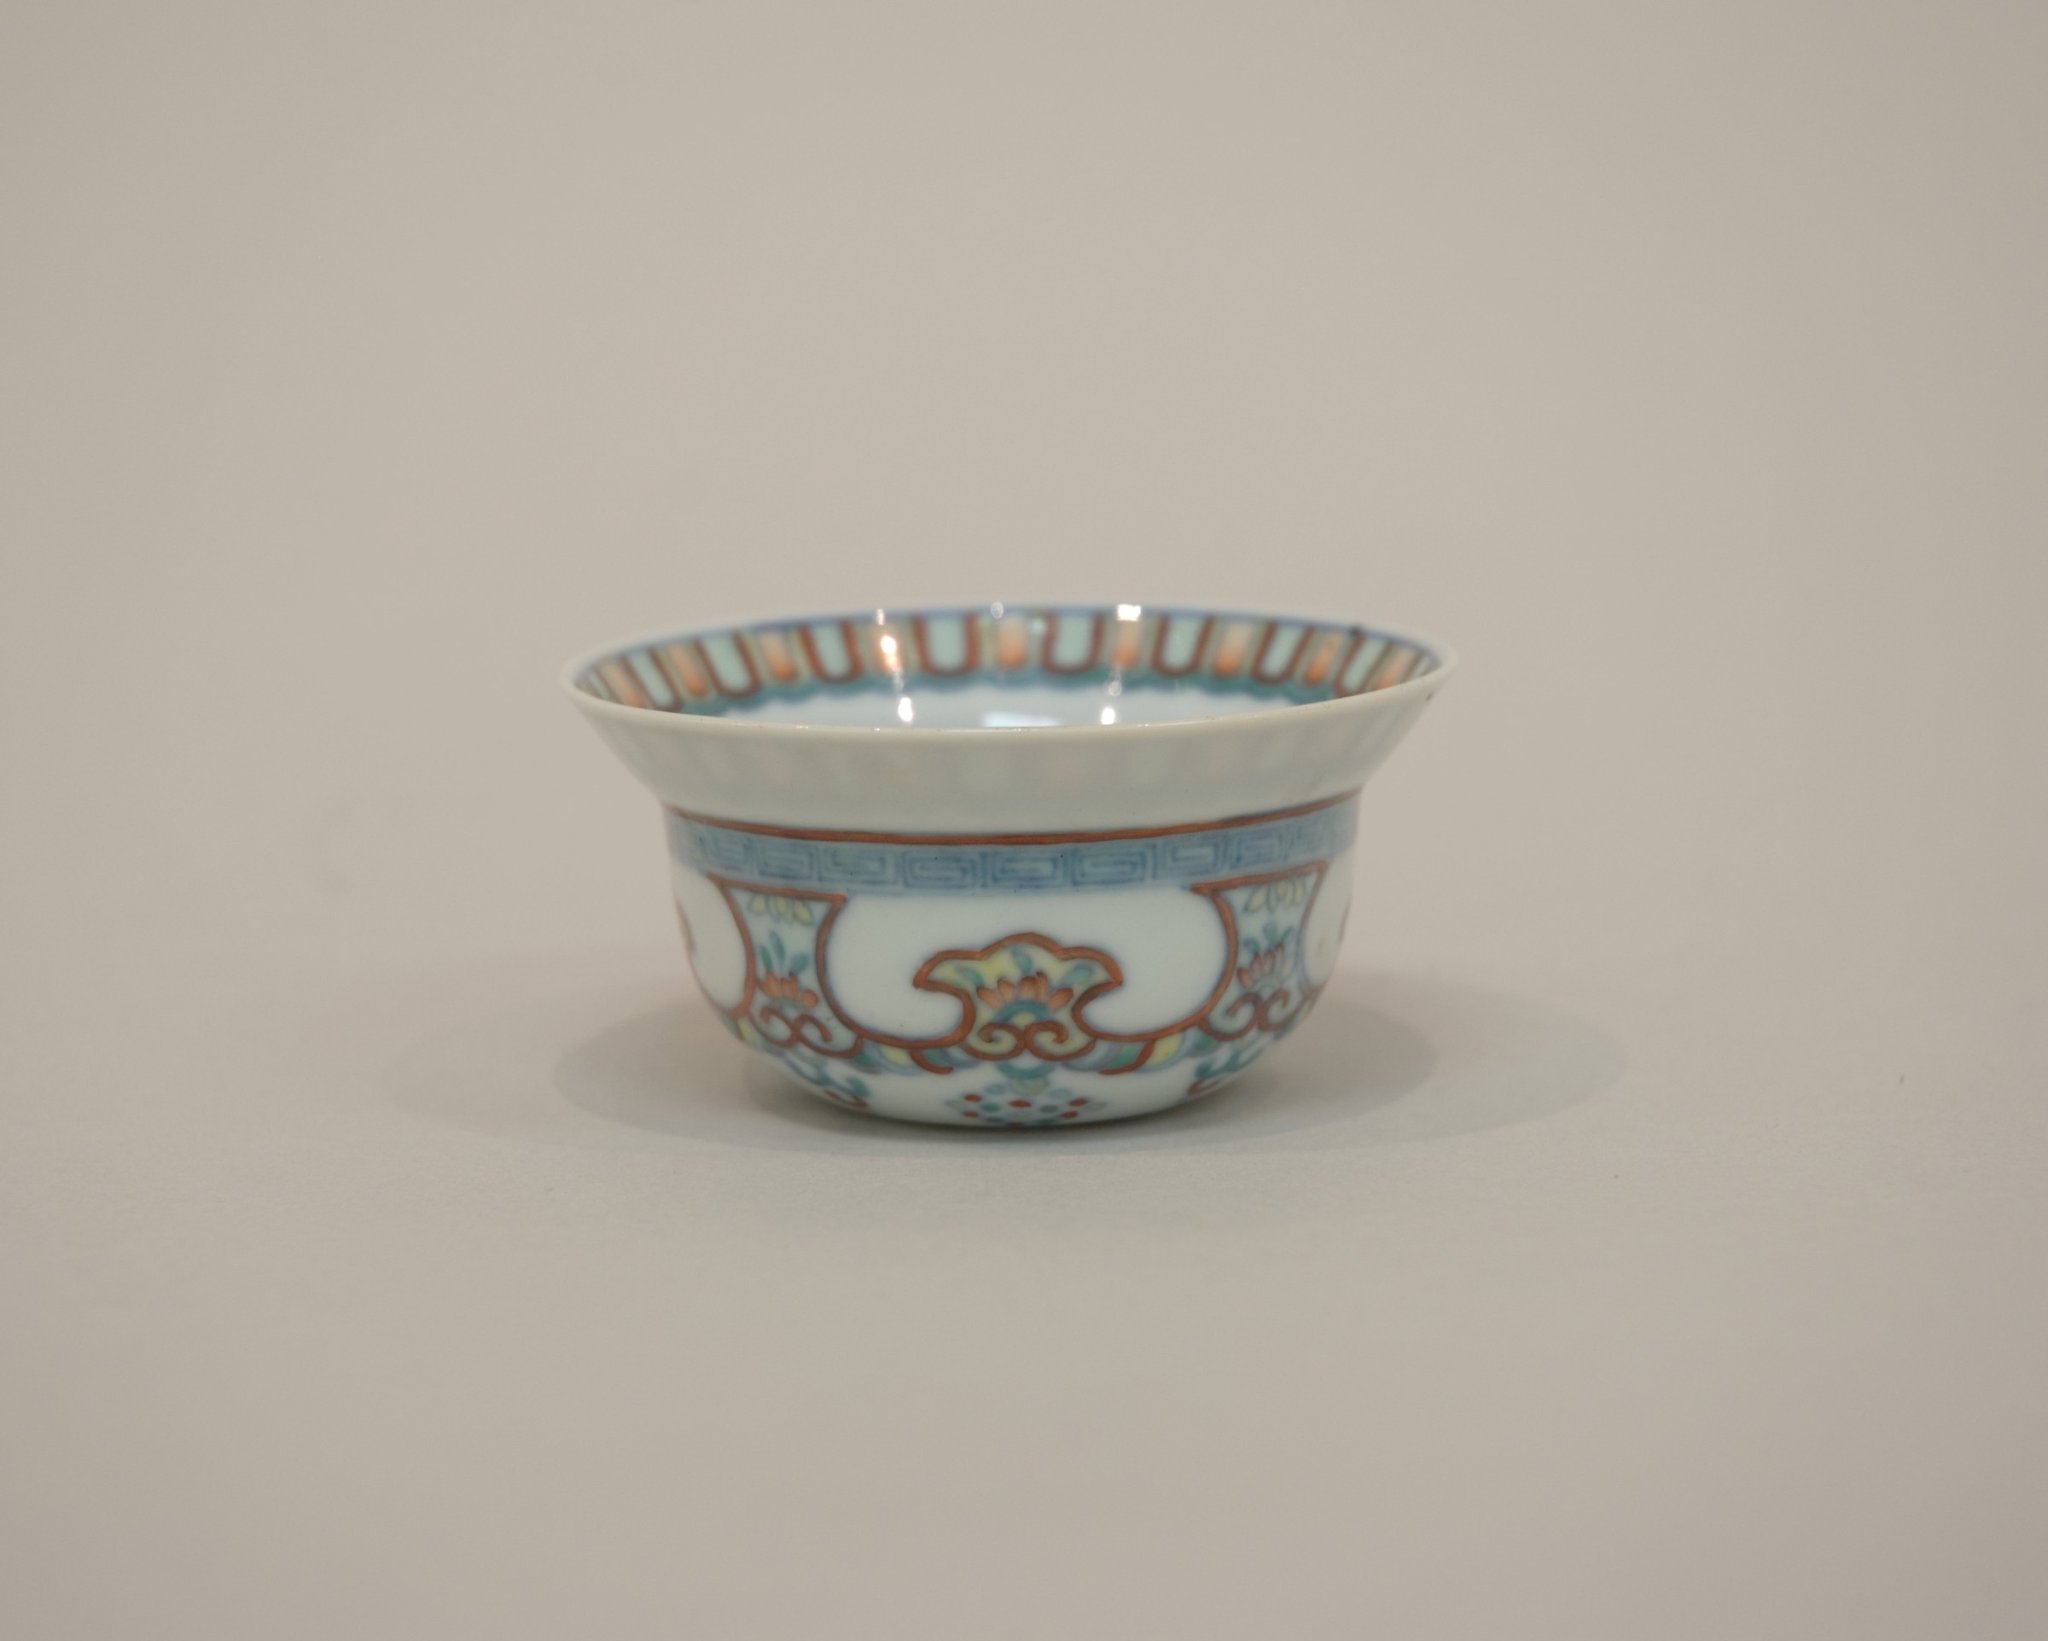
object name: cup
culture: chinese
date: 1801-1900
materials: enamel, porcelain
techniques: overglaze, painting, polychrome